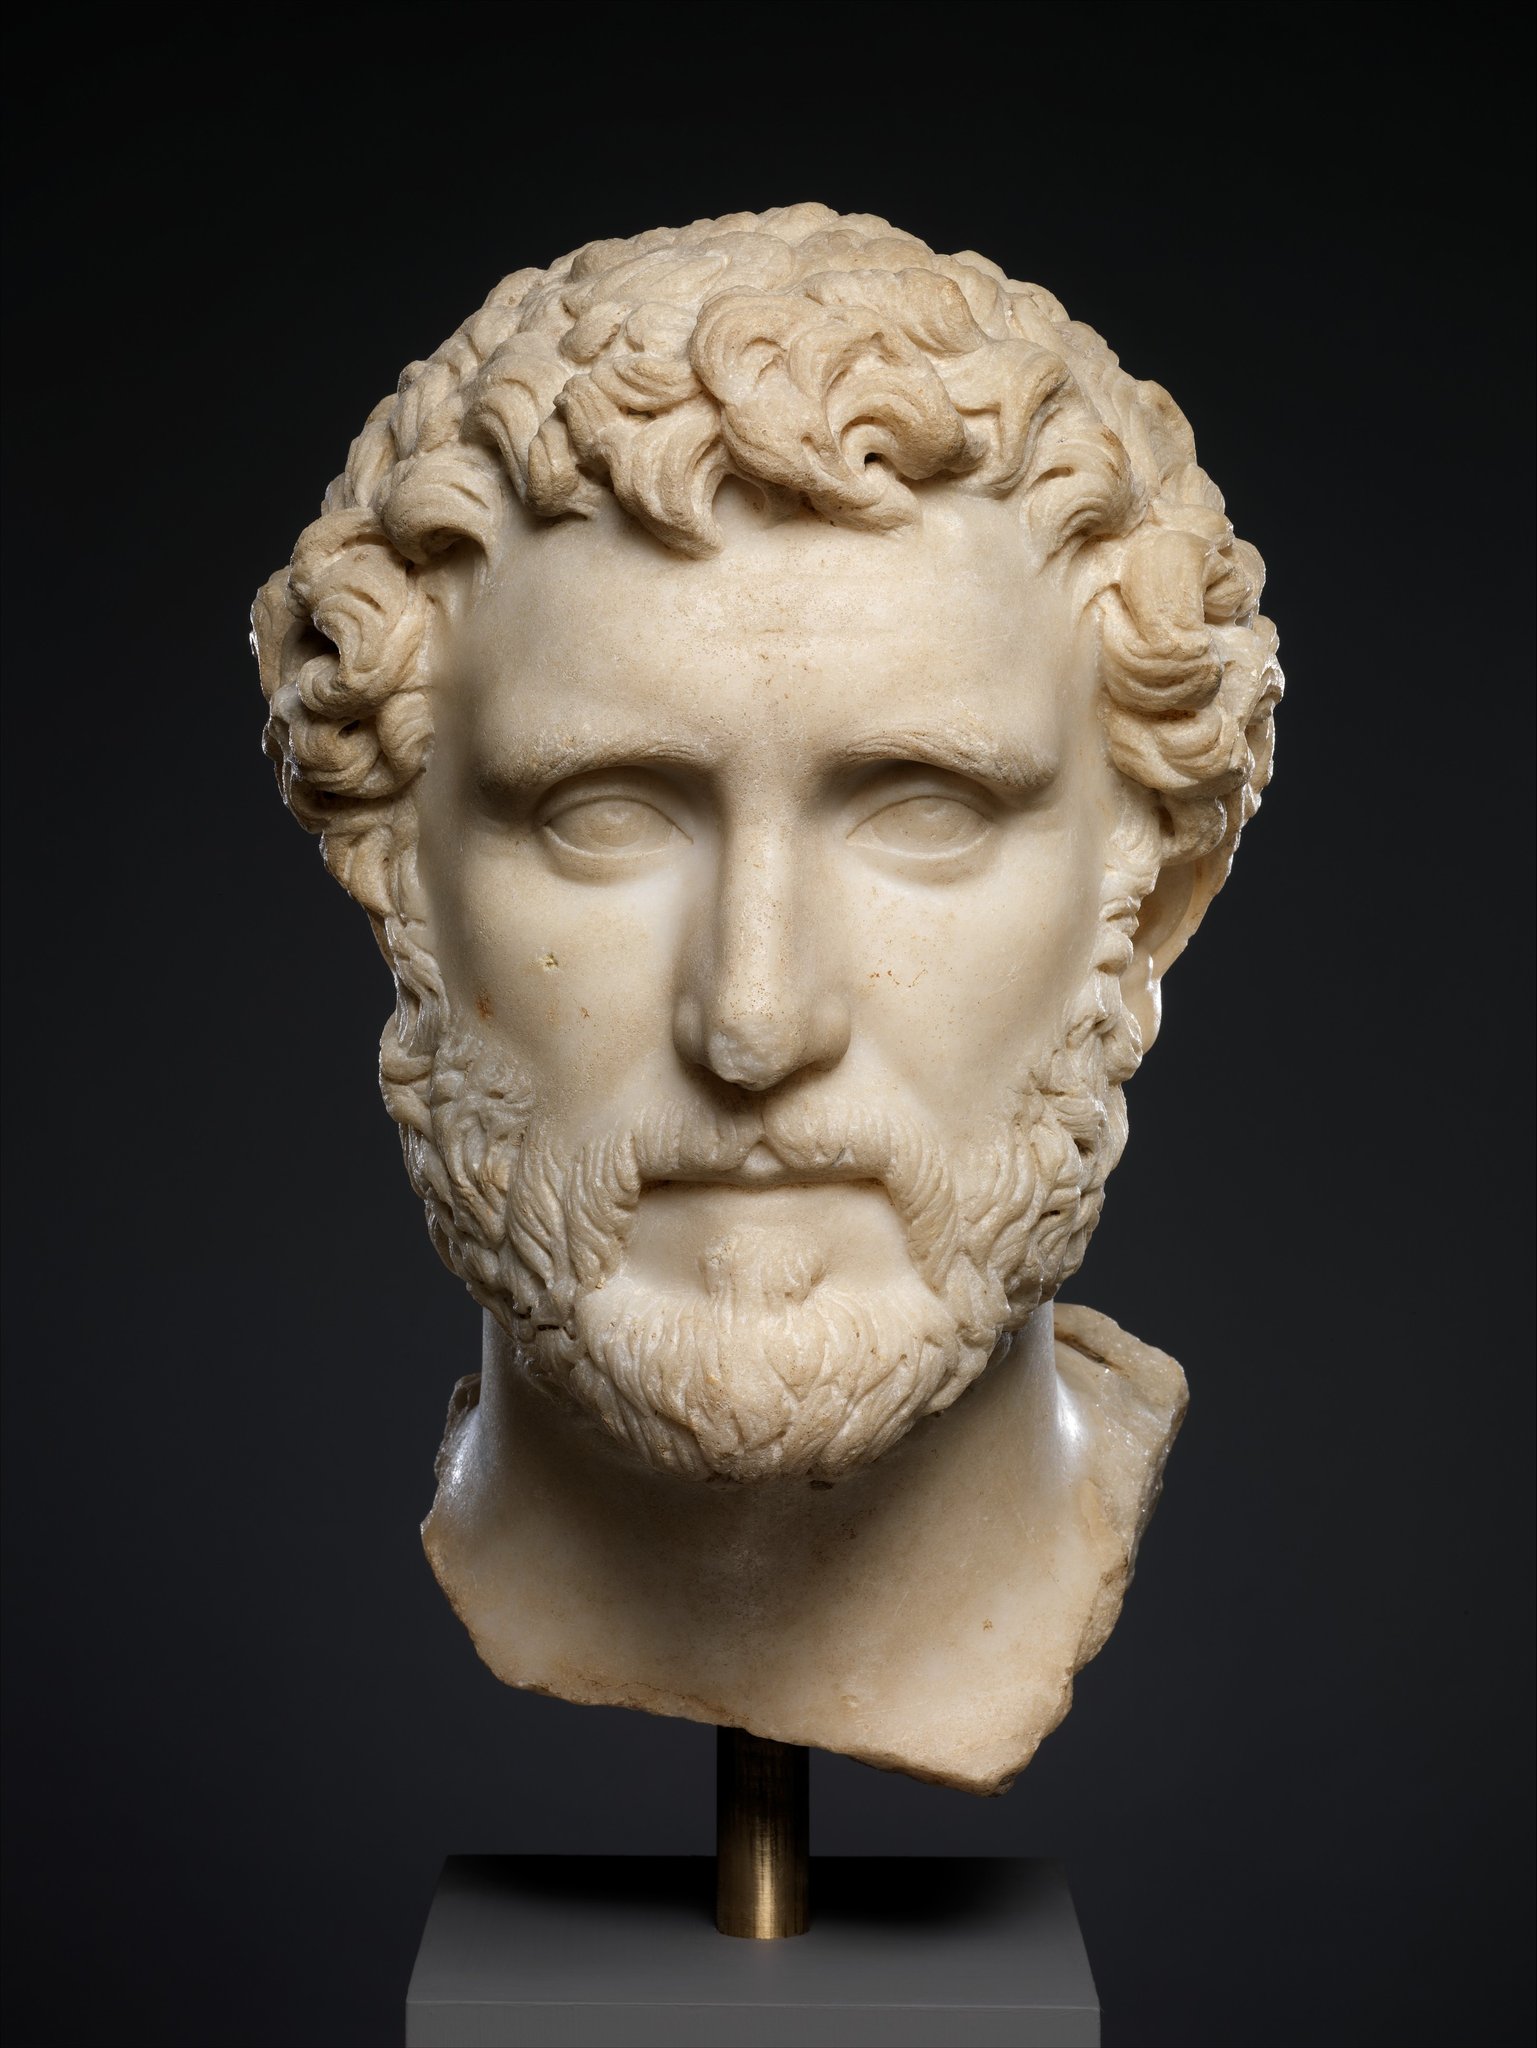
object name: portrait head of the emperor antoninus pius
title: Marble portrait of the emperor Antoninus Pius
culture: roman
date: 138-161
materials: marble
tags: heads,men,portraits